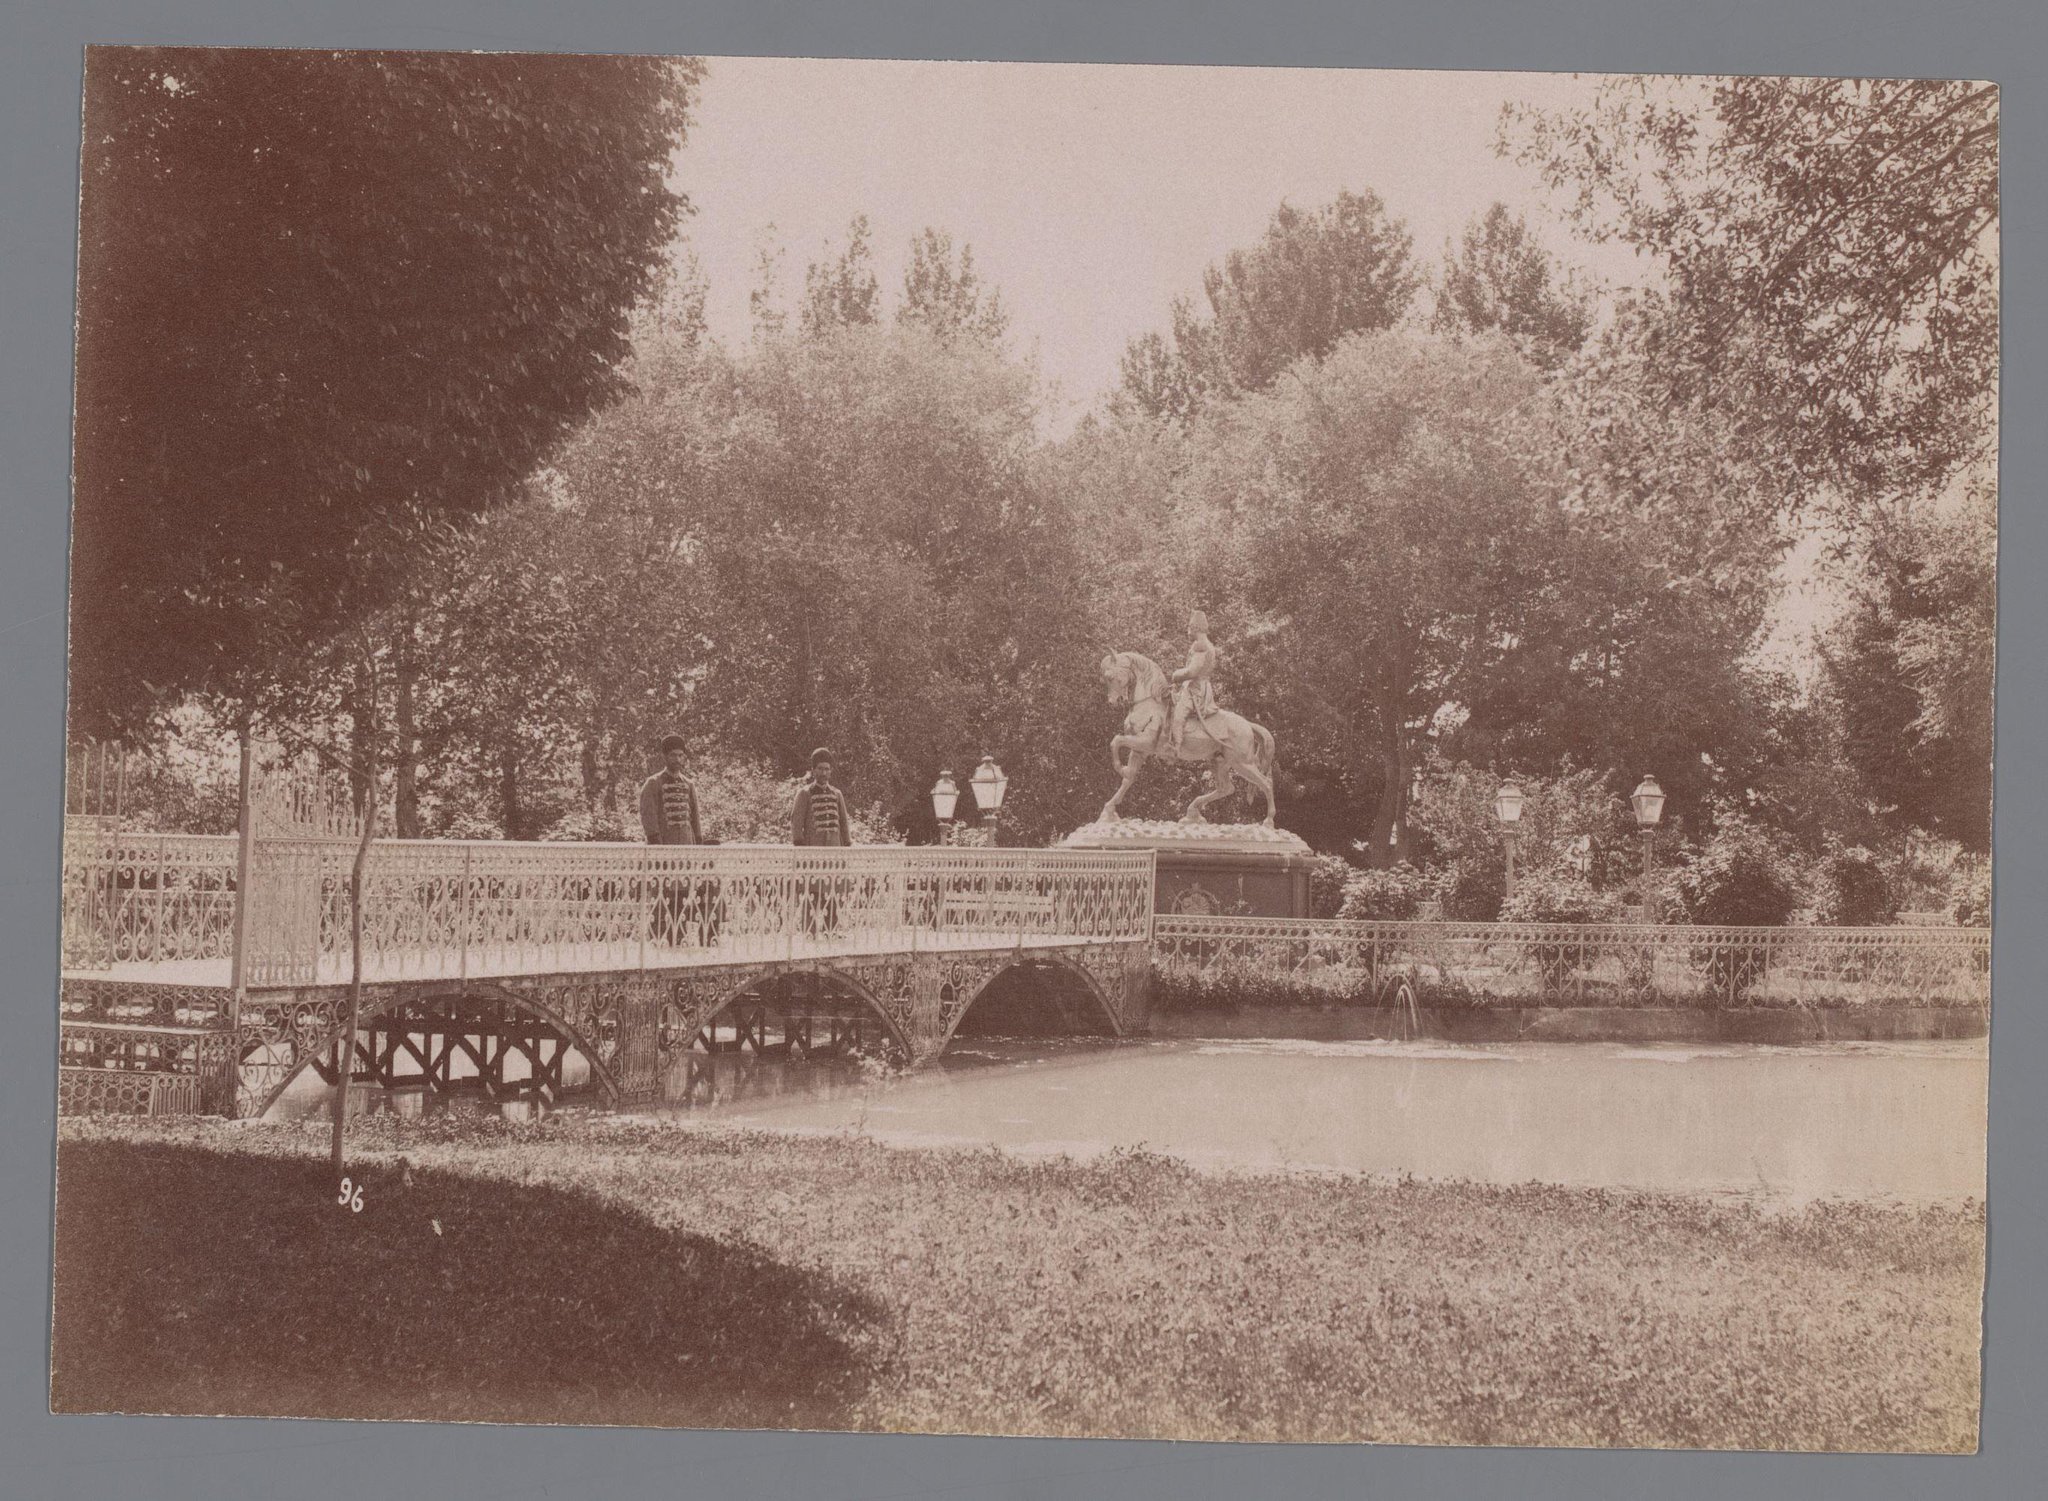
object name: photograph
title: Baghi Cha, Teheran, Iran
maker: antoine sevruguin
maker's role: fotograaf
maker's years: 1840-1933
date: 1880-1910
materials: paper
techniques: albumen print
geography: iran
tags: teheran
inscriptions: inscription: ‘Teheran Baghi Cha’